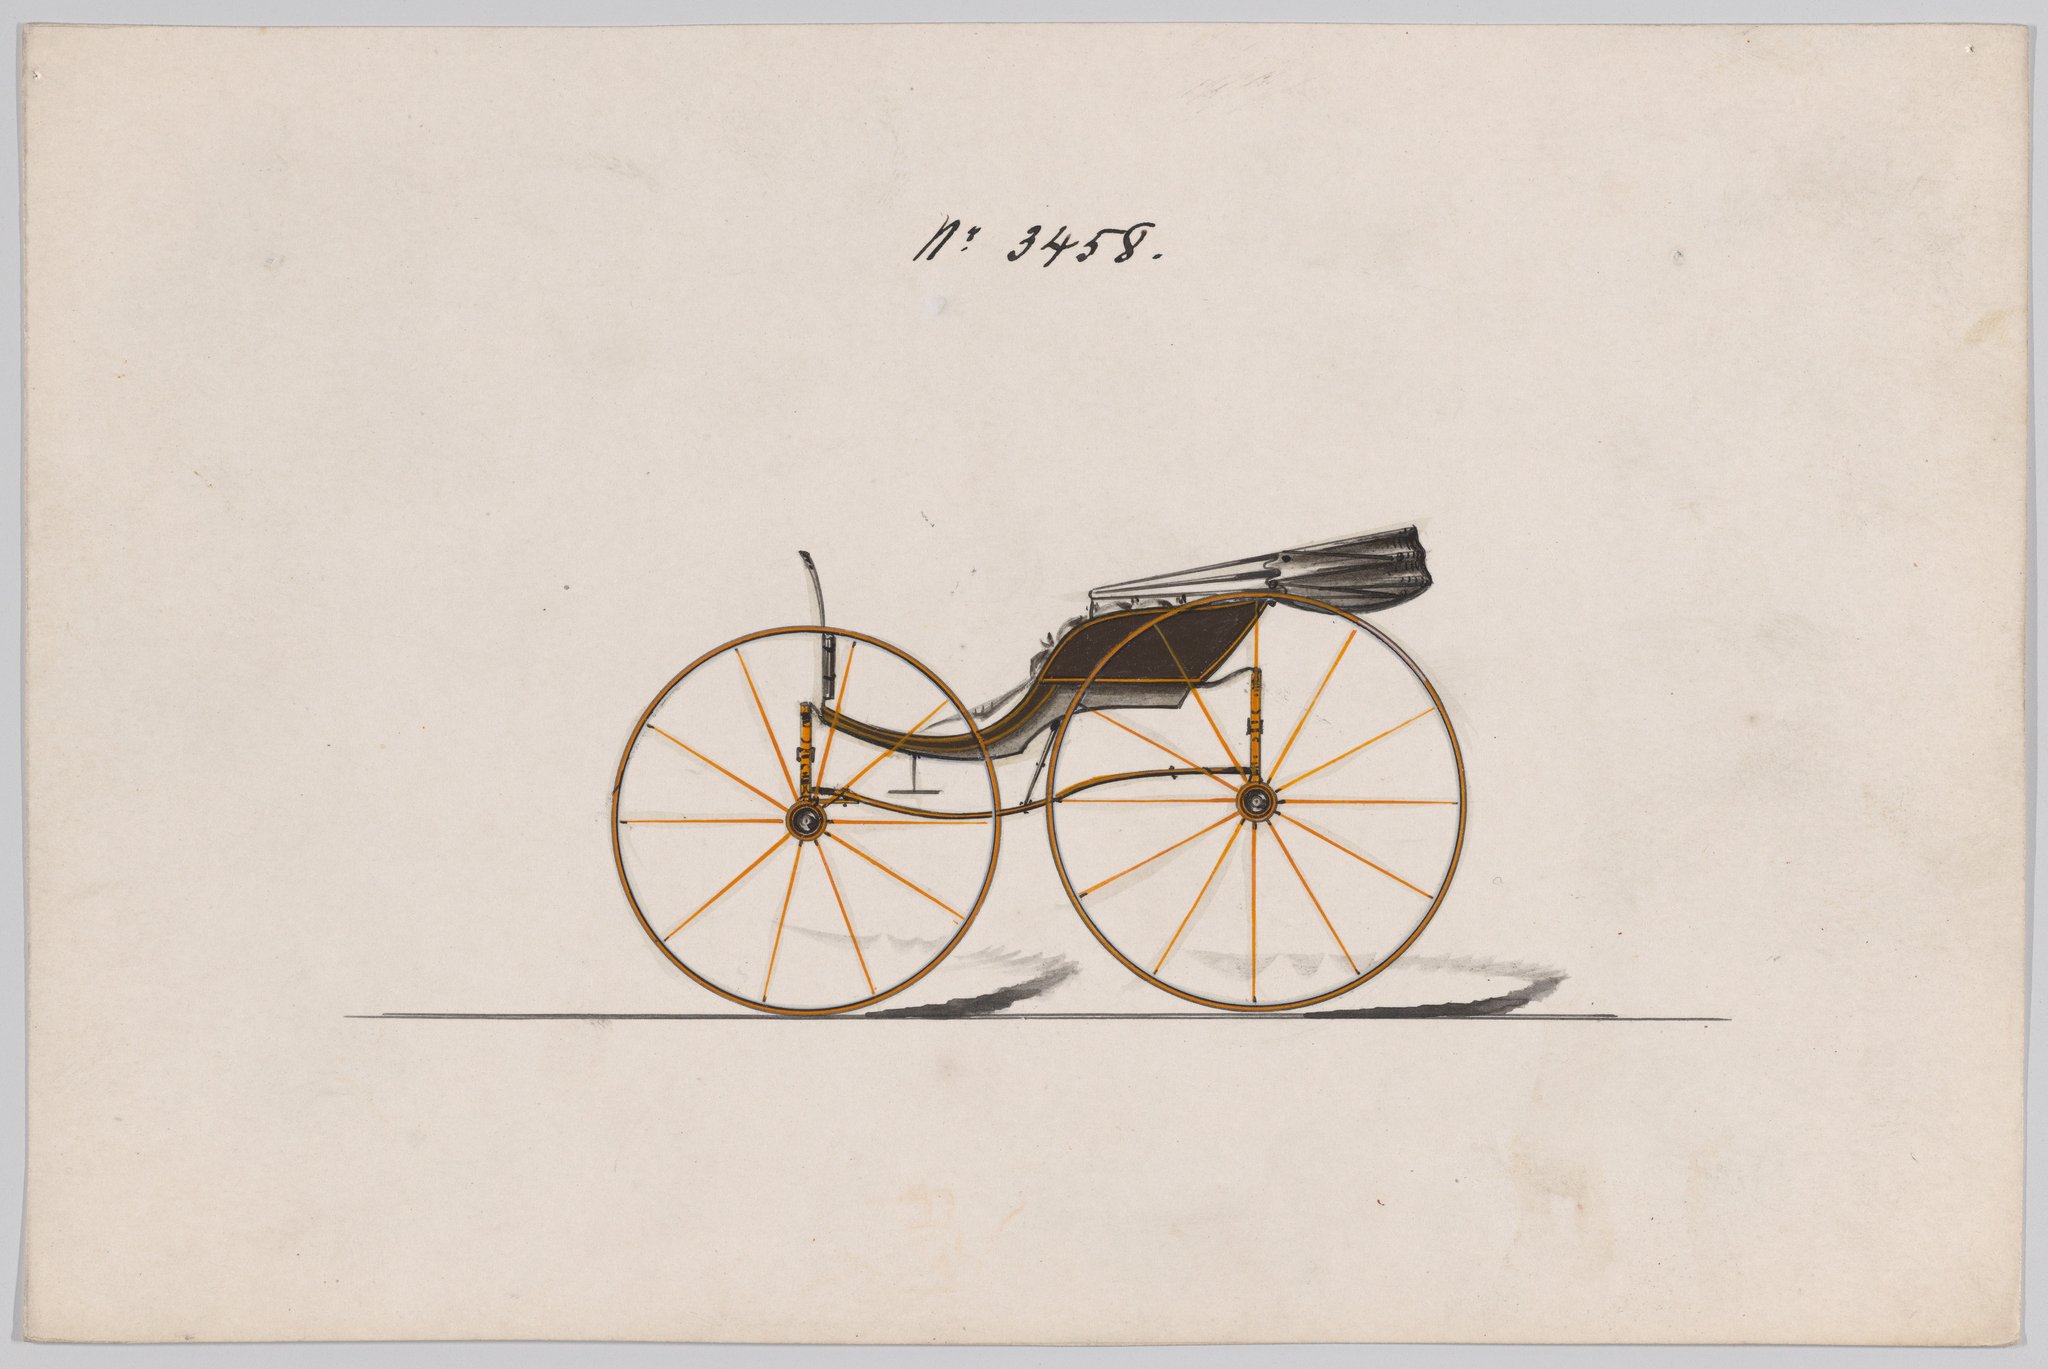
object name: drawing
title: Design for Pony Phaeton, no. 3458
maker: brewster & co.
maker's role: manufacturer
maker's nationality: american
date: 1878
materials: gouache, gum arabic, ink, watercolor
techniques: pen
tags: carriages